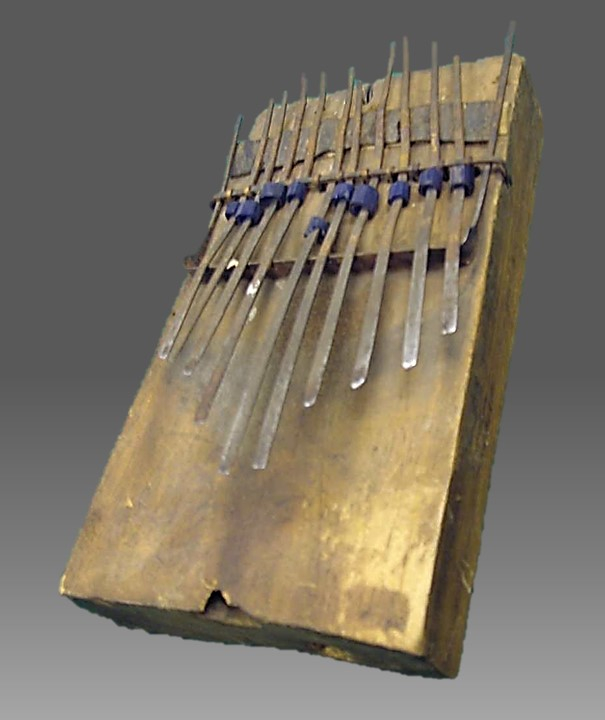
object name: zanze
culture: central african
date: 1867-1900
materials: glass, metal, wood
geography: congo